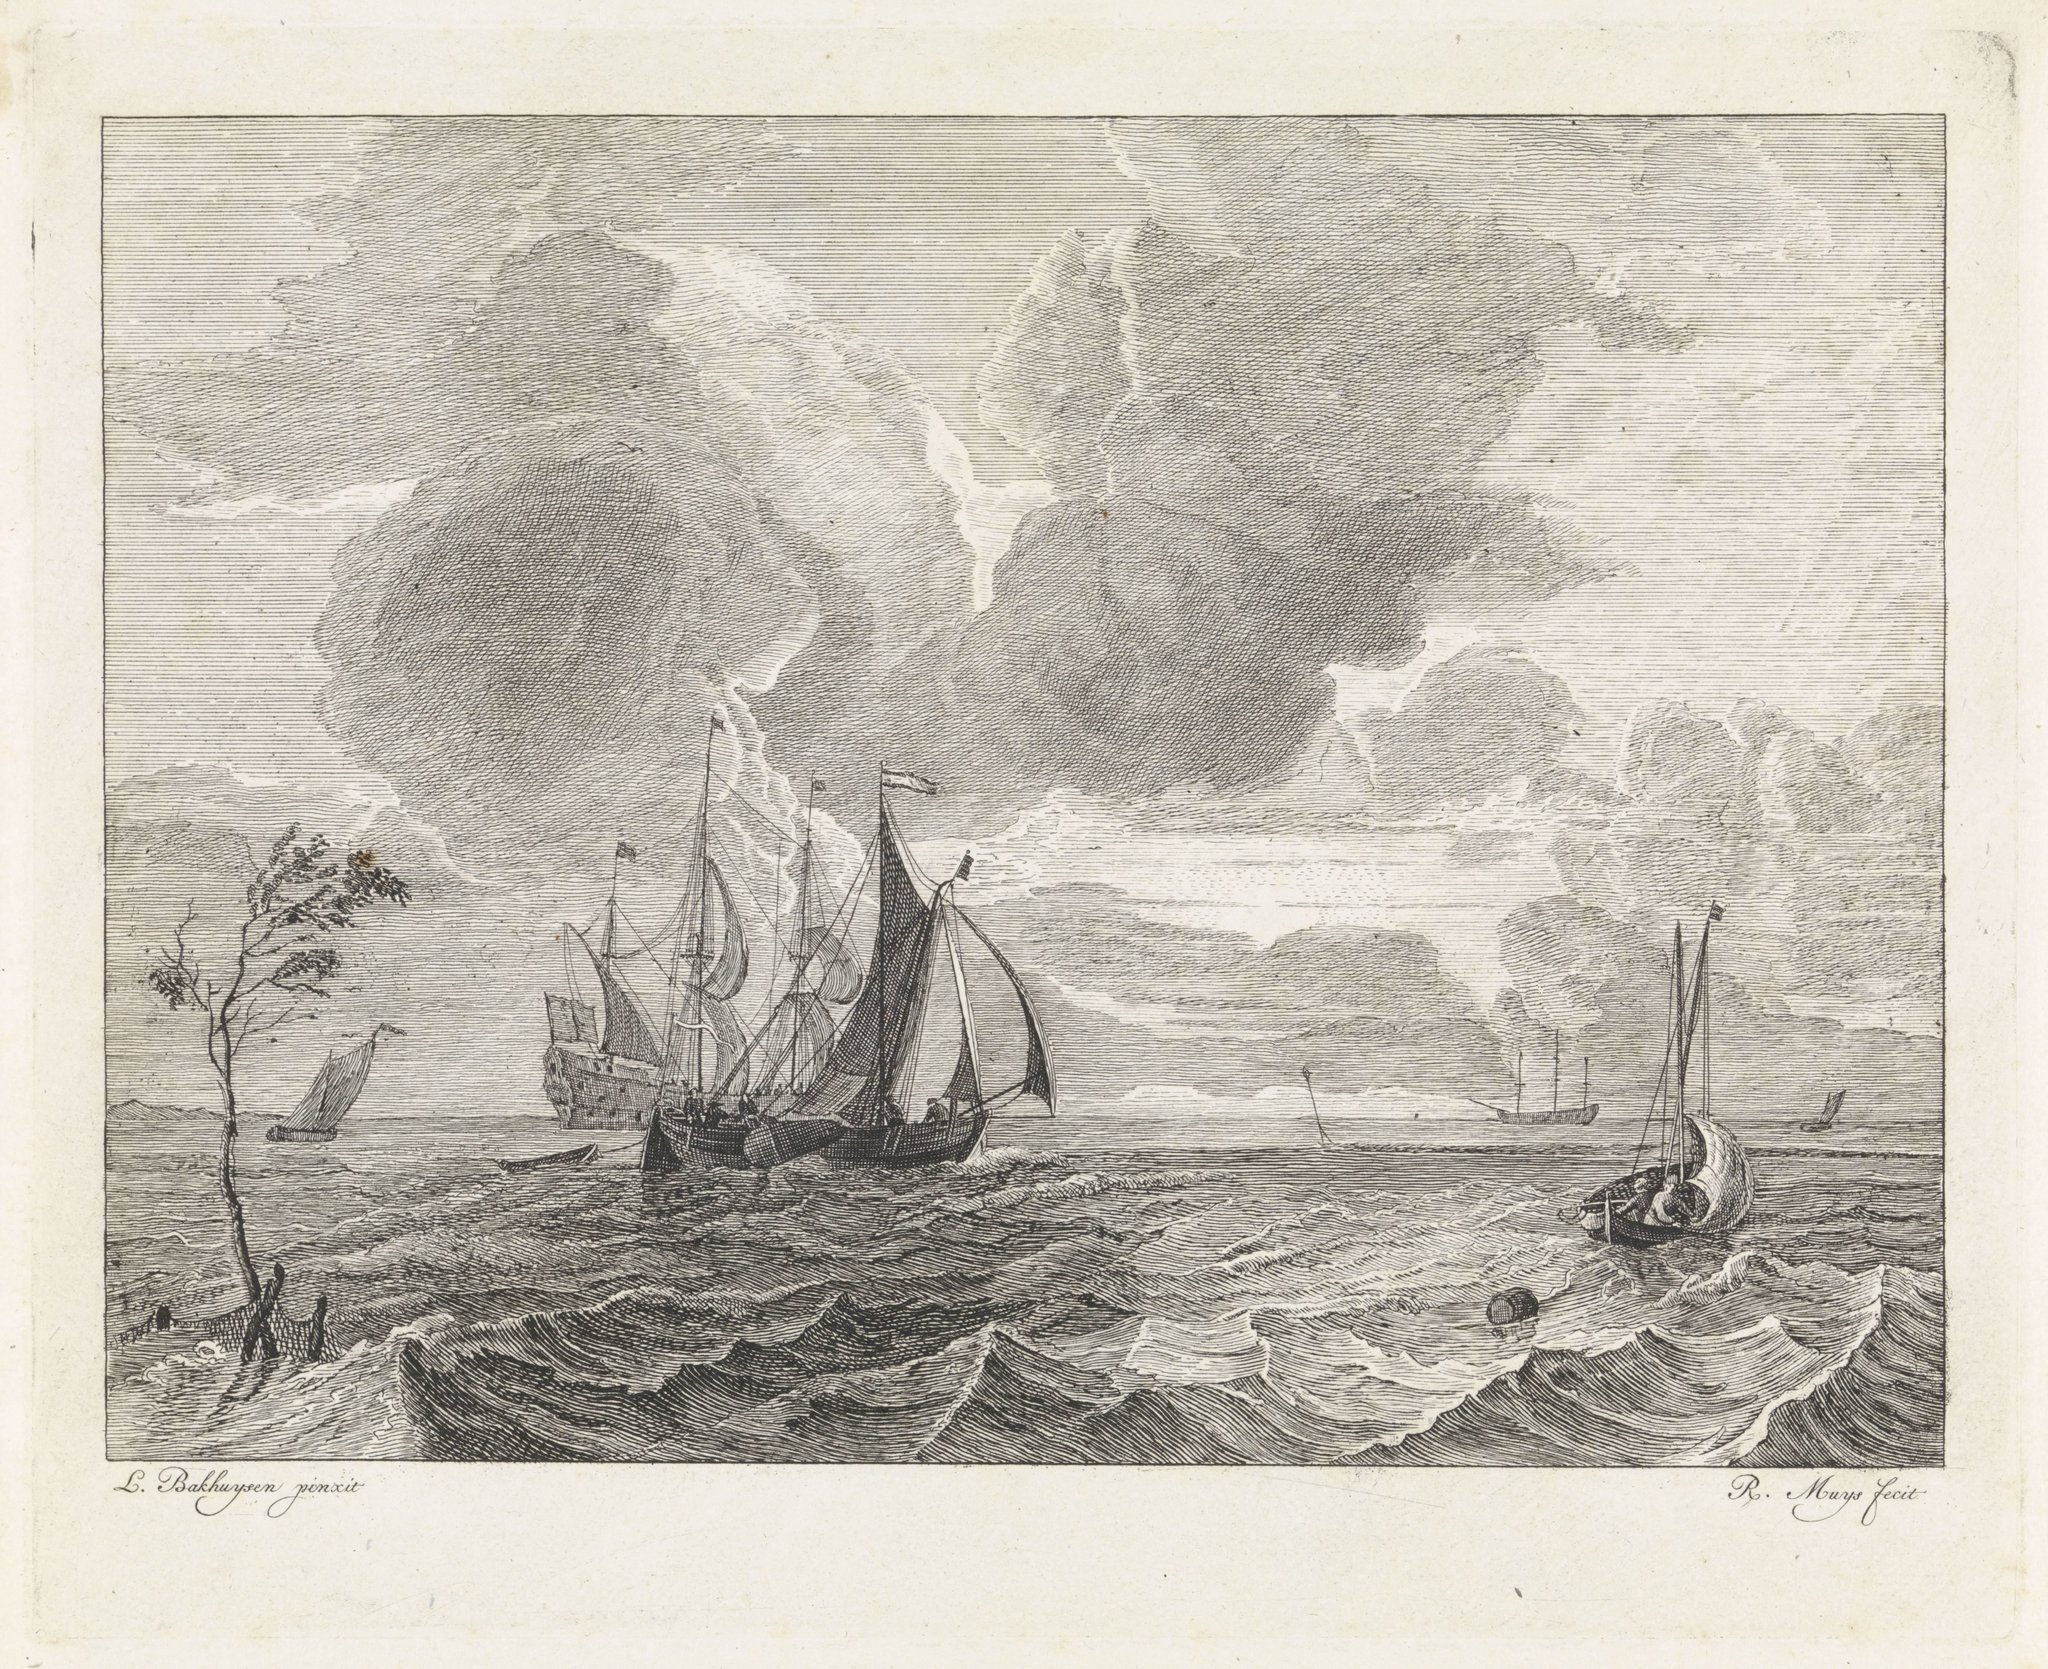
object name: print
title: Zeilschepen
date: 1752-1825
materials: paper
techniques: etching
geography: rotterdam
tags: sailing-ship, sailing-boat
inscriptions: collector's mark: Lugt 2228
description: Verschillende zeilschepen op een golvende zee. Links een klein zeilscheepje met twee mannen aan boord, achter het scheepje drijft een ton. In het midden twee grote zeilschepen. Links in het water een boompje en een vissersnet.